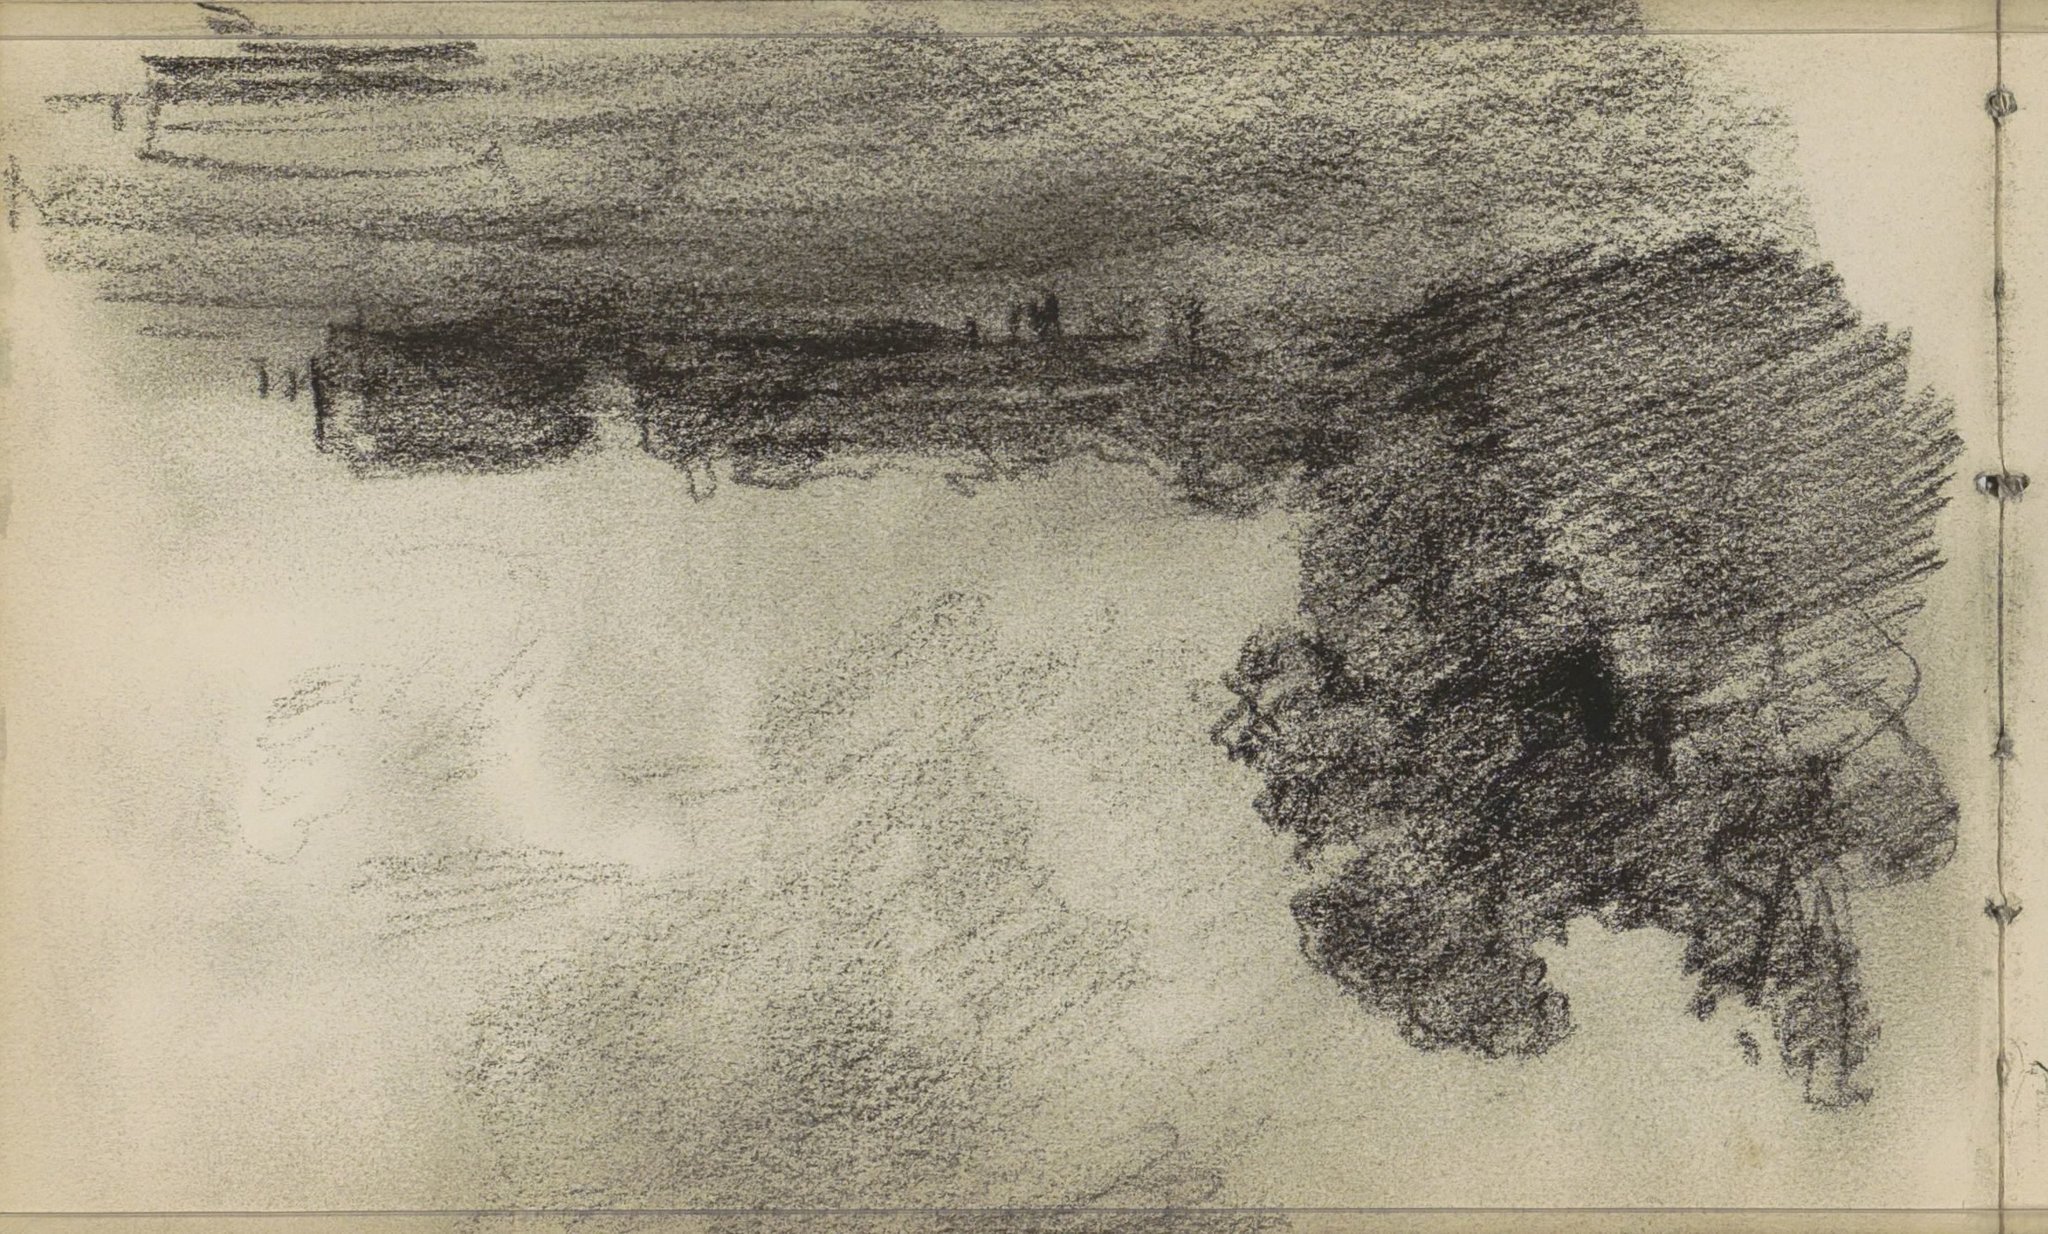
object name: sketchbook leaf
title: Landschap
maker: johan antonie de jonge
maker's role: draughtsman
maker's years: 1864-1927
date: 1901-1927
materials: chalk, paper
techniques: stumping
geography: south holland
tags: trees, landscapes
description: Landschap. Blad 30 verso uit een schetsboek met 45 bladen.